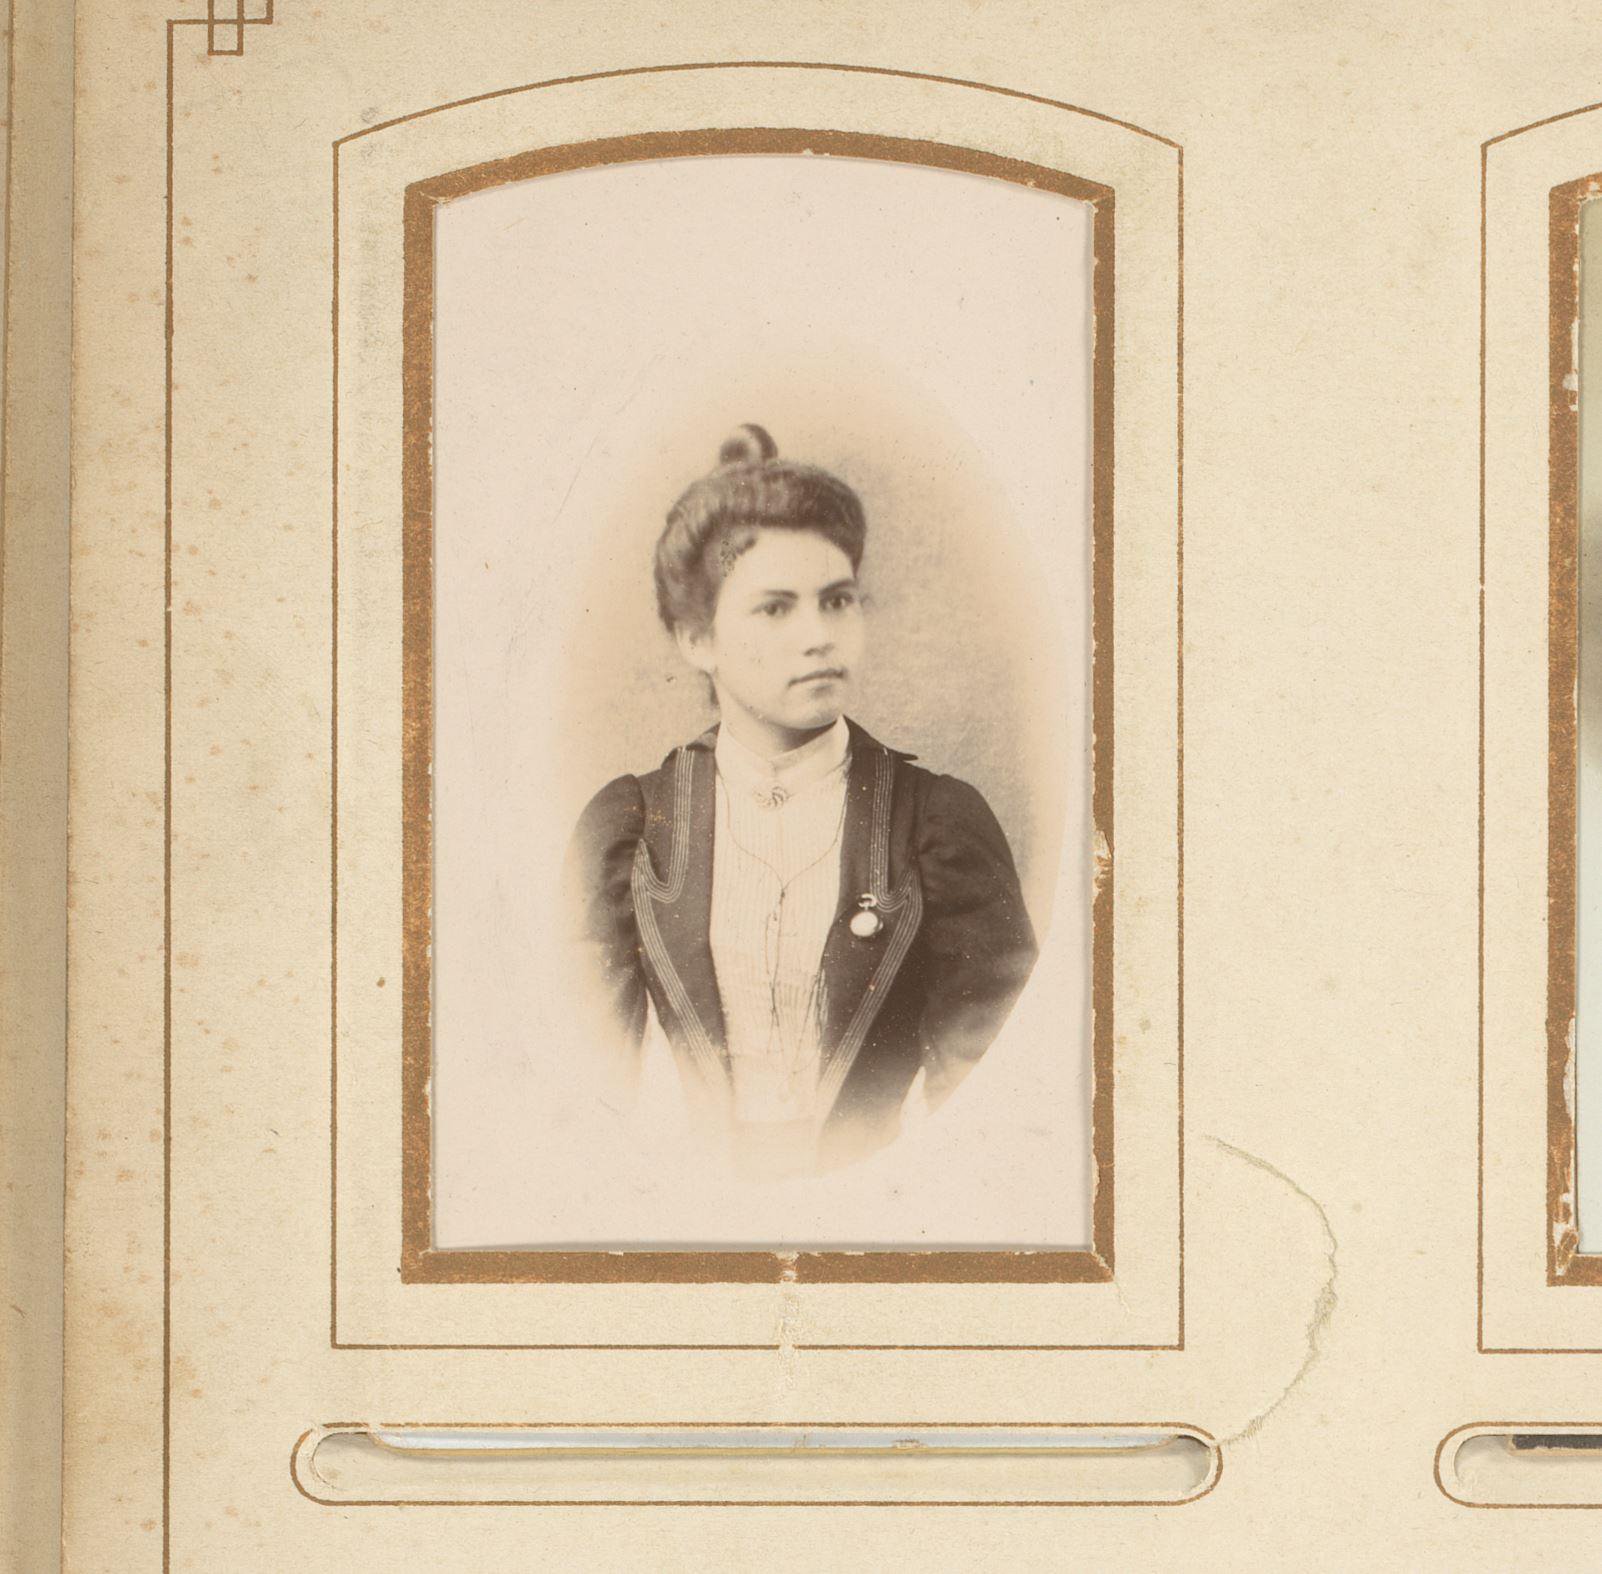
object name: album leaf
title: Portret van een vrouw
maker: a. jacquelin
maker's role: fotograaf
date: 1860-1900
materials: cardboard, photographic support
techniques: albumen print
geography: nevers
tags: historical persons - bb - woman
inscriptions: inscription: ‘Photographie [...] A. Jacquelin/ 18, Rue de Paris, 18/ Nevers’